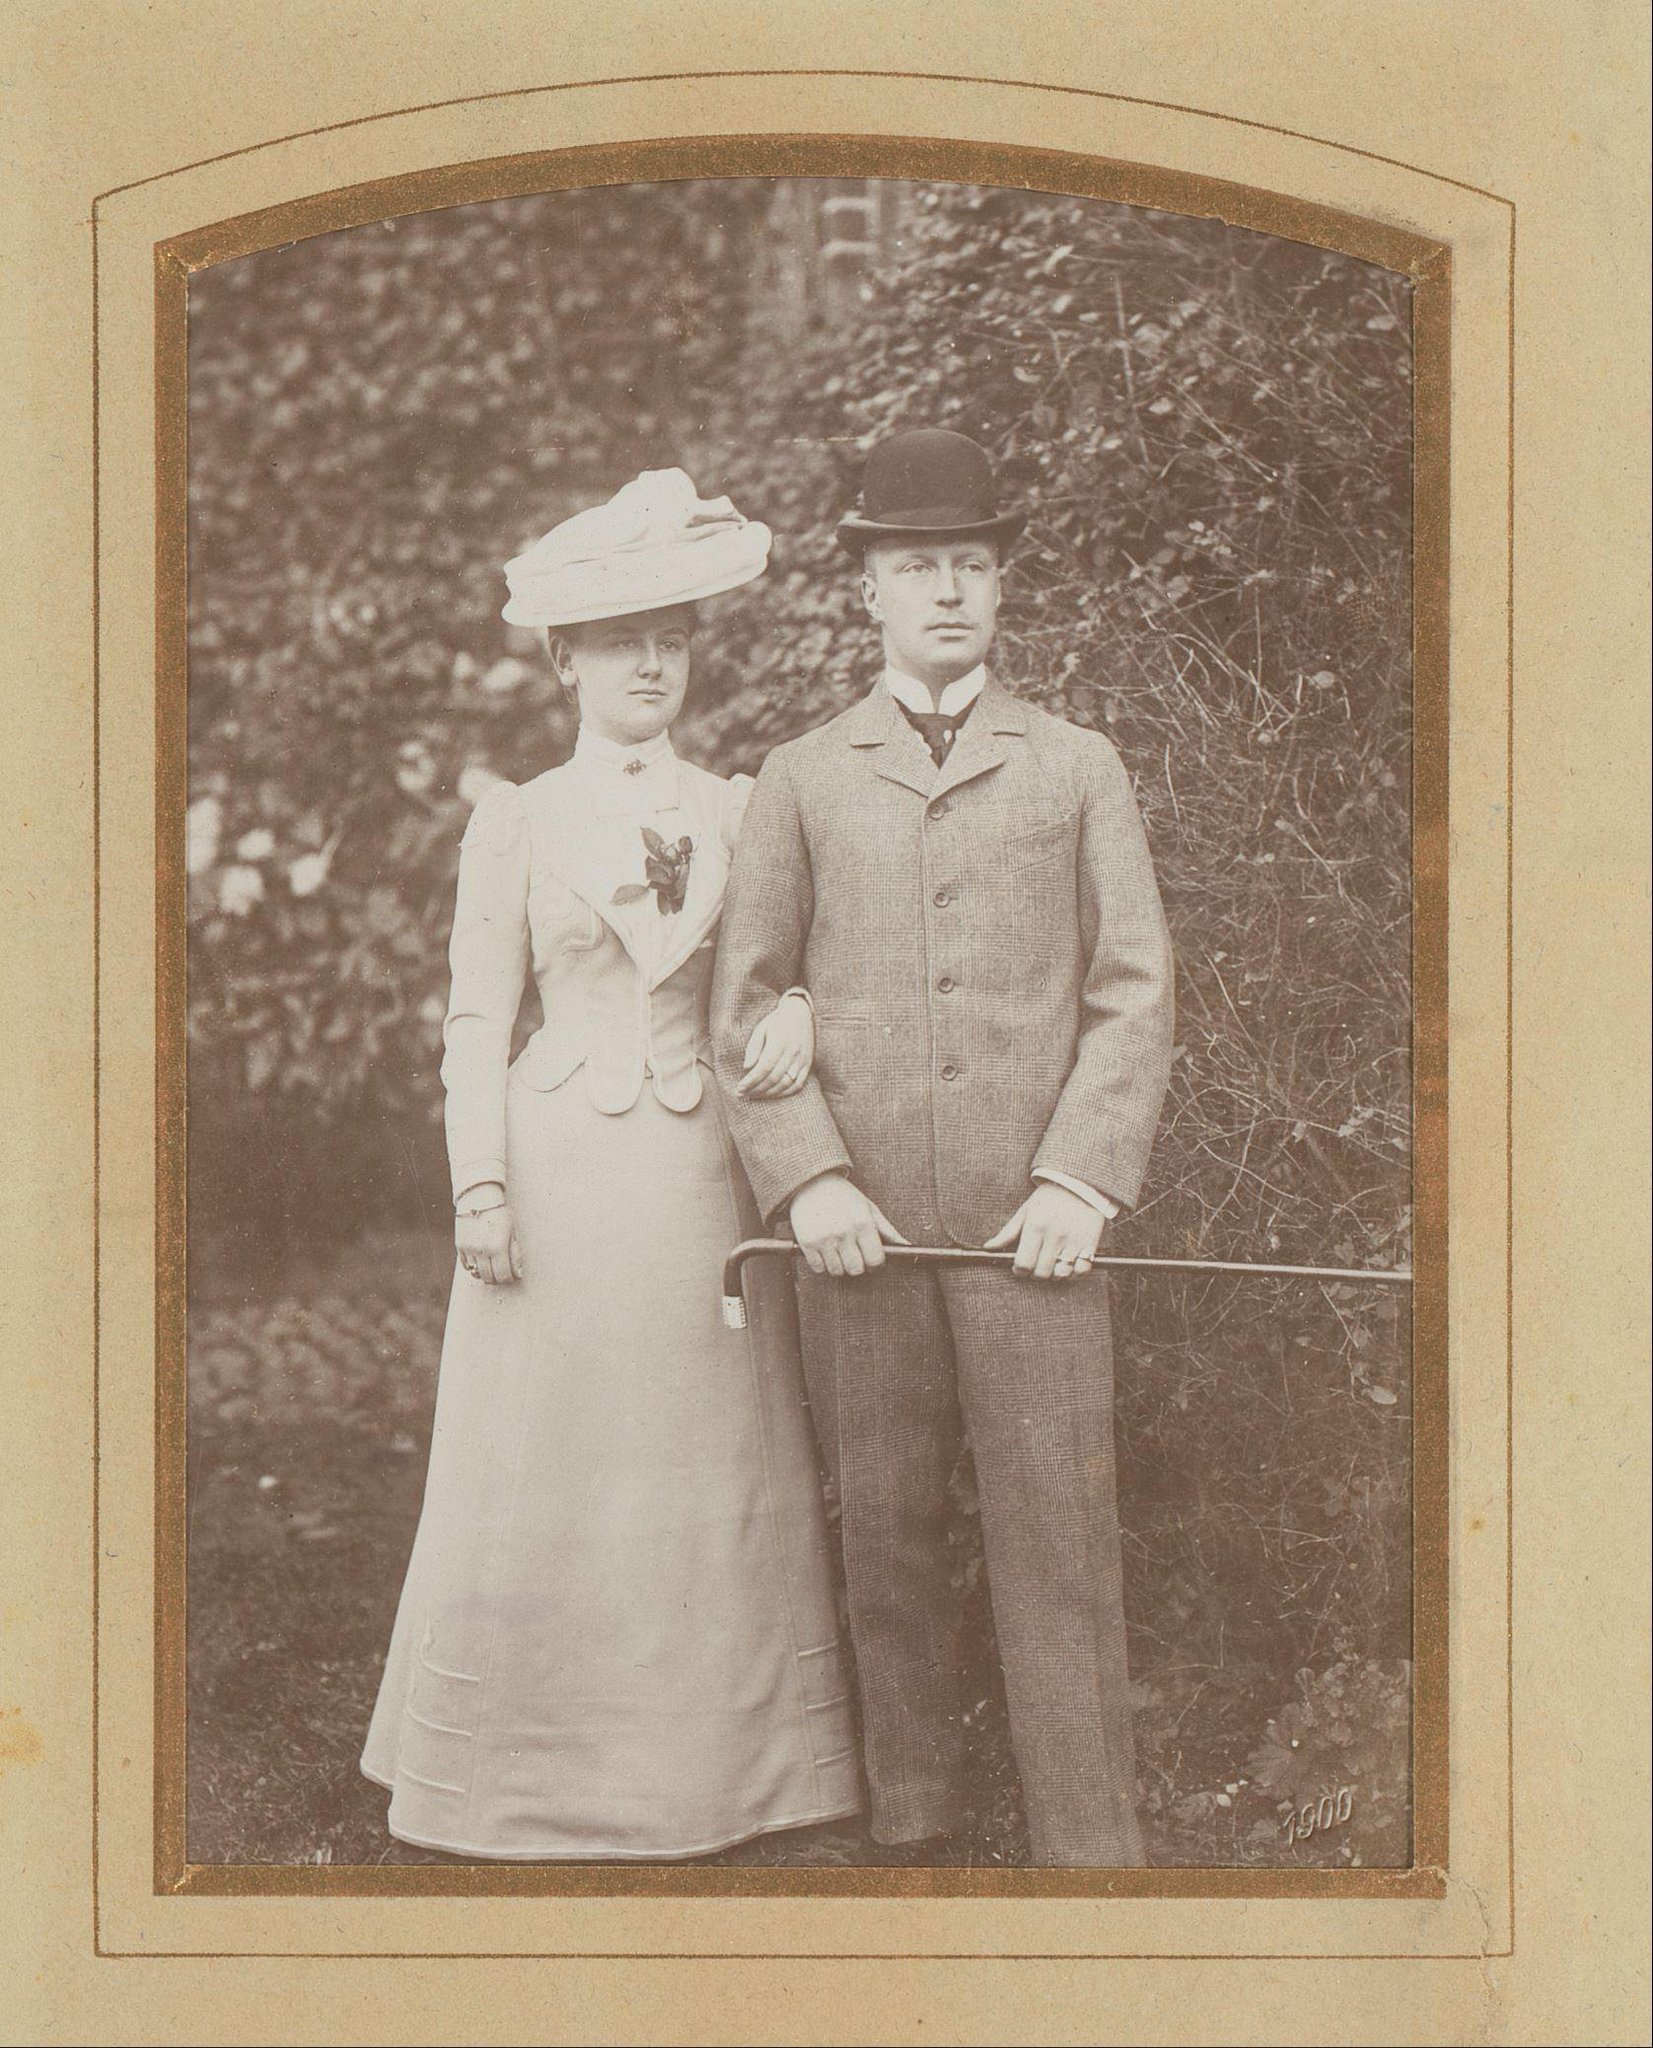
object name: cabinet photograph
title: Verlovingsportret van koningin Wilhelmina en prins Hendrik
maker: Anonymous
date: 1900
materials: cardboard, photographic support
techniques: collodion silver print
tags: wilhelmina of the netherlands, the hague, hendrik (prins der nederlanden (1876-1934)), queen, betrothal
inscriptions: number: ‘1900’